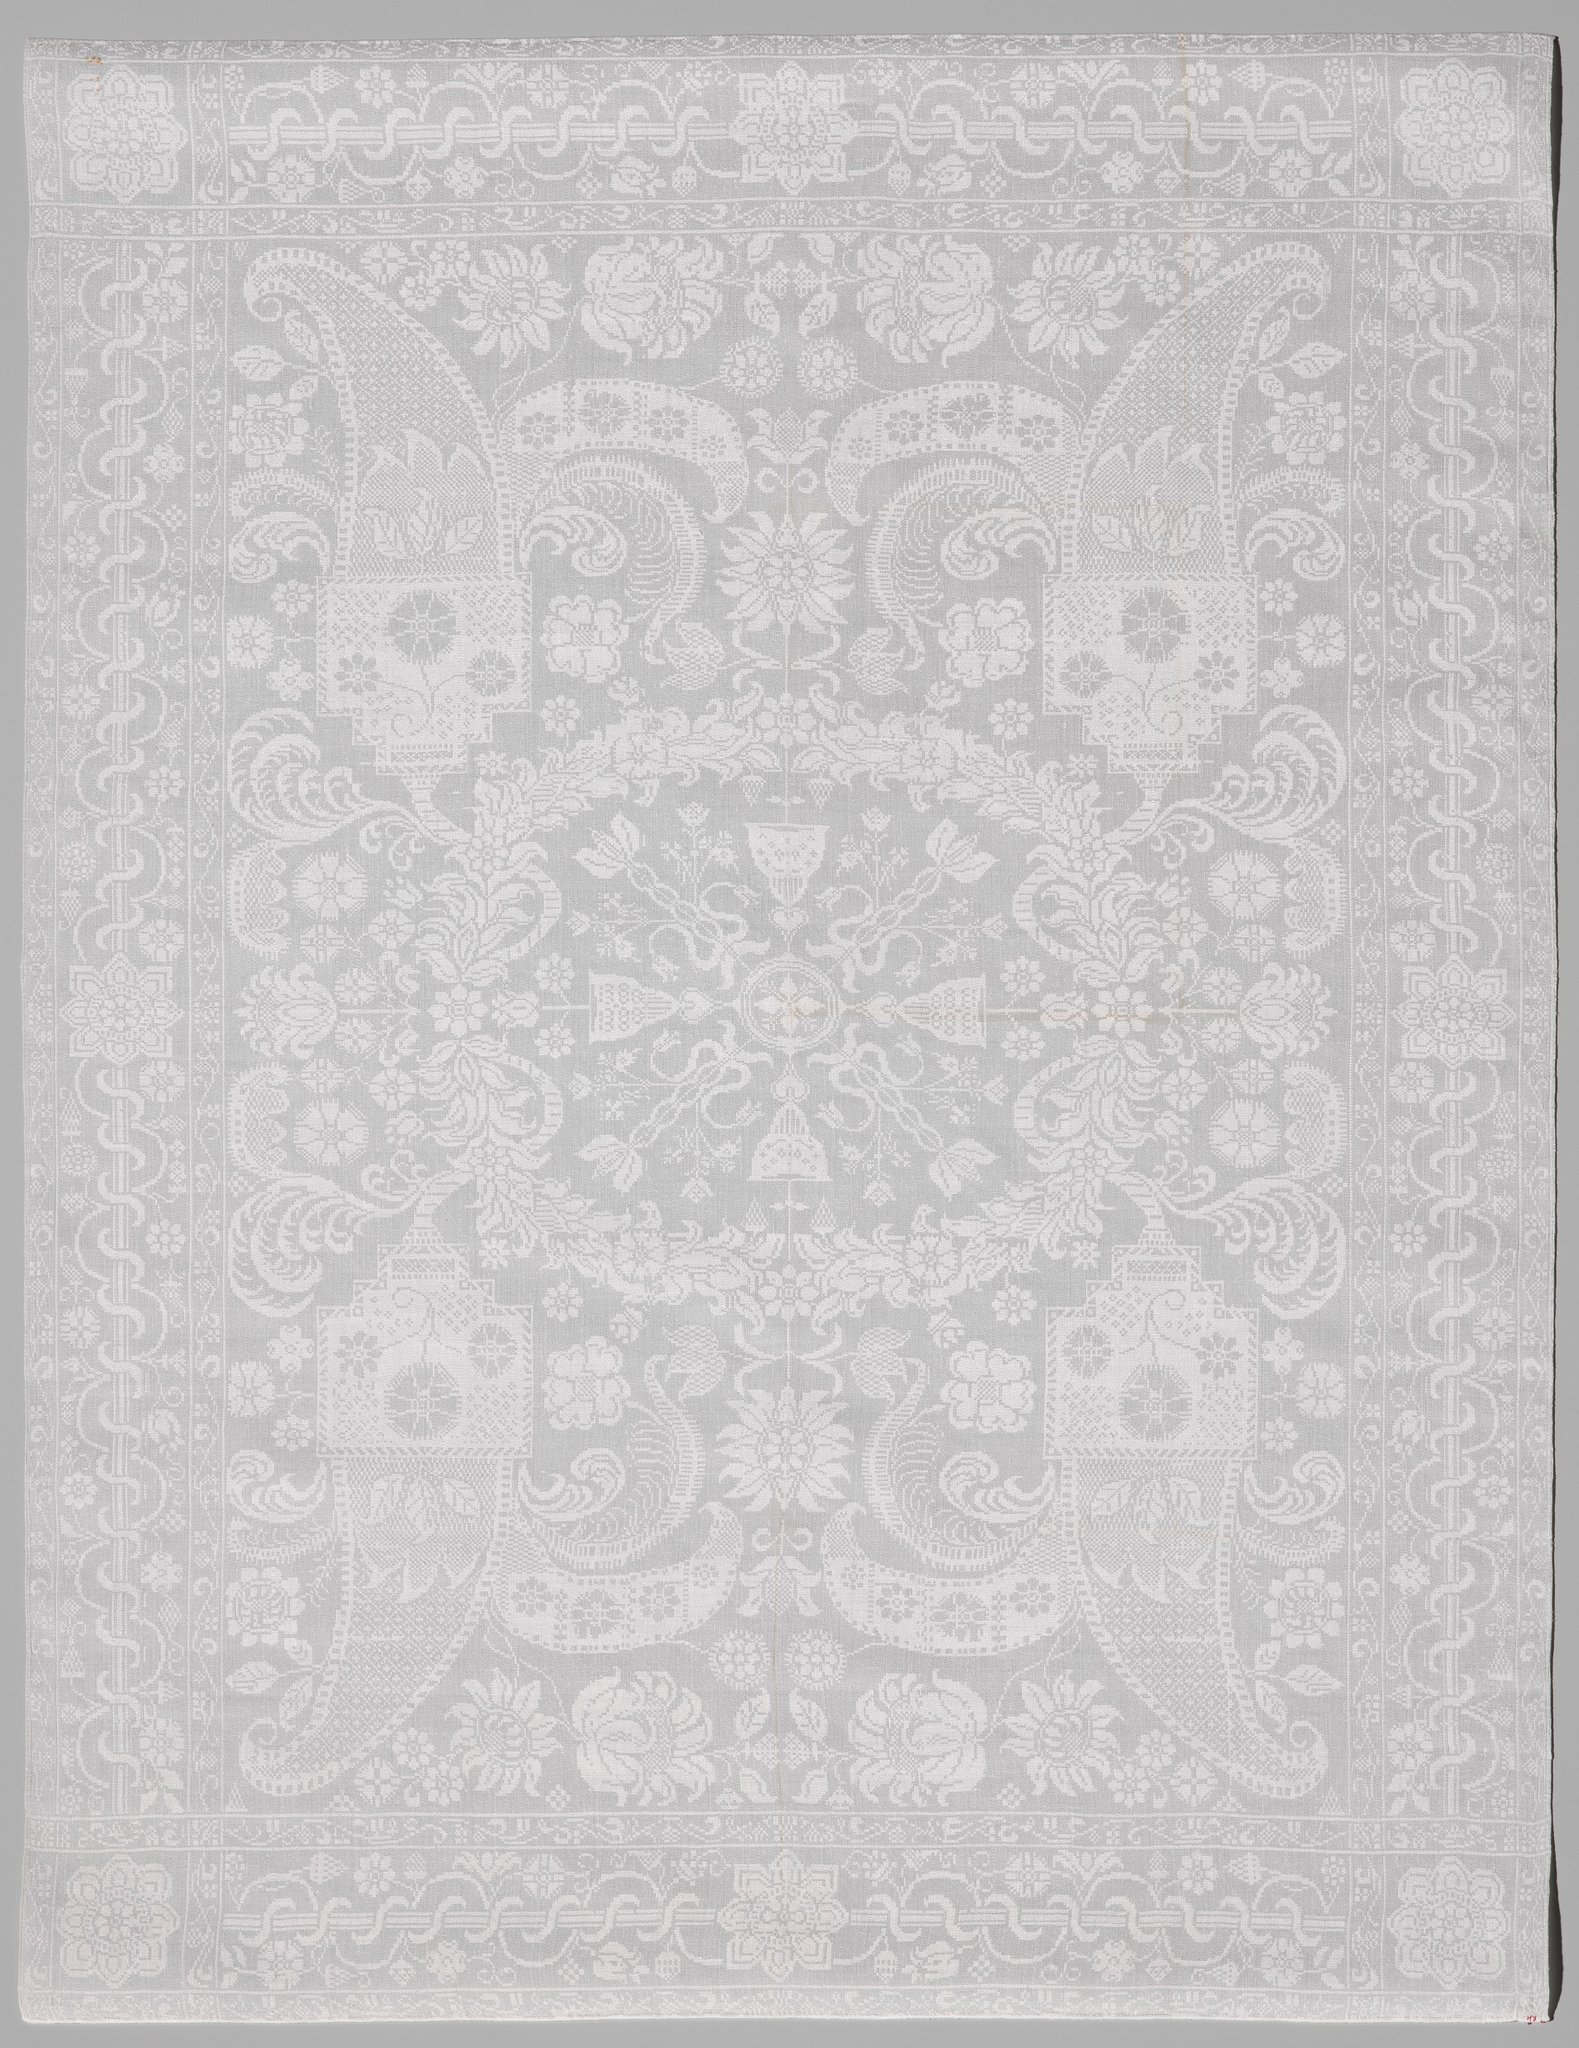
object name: napkin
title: Servet met gestileerd patroon van een krans en 'boteh's'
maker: Anonymous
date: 1700-1725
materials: linen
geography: flanders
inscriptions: : ‘kroon (?) en 24 p poon’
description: Servet van wit linnendamast met een vierzijdig symmetrisch patroon. In het midden een cirkel van waaruit, diagonaalgewijs, zeer gestileerde bloemornamenten ontspruiten; op de ruimte daartussen bloemvazen. Het geheel wordt omsloten door een bloem- en bladerkrans waaruit terzijde stengels ontspringen waaruit bladvoluten ontspruiten en die eindigen in een eigenaardig ornament dat de hoeken van het middenveld van het servet vult. Dit ornament bestaat uit een hoekige, met een bloemtak versierde, nap of vaas waaruit een 'boteh'-achtige versiering tevoorschijn komt gevuld met een bladmotief en voorts met servetwerk. Van de contouren van deze 'boteh' ontspringen weer bloemtakken, voluten en een lancetbladvormig ornament versierd met bloemen. In het midden van de lopende en van de liggende randen een gestileerde stervormige bloem met aan weerszijden een staaf of stang die zowel omwonden wordt door een lint als door een tak met bladeren, bloemen en vruchten. Deze randen worden geflankeerd door smalle randen waarbinnen een golvend takje met bladeren, bloemen en vruchten. In de hoeken een gestileerde bloem. Merk: restanten van kroon, initiaal en 24 in bruine kruissteek.